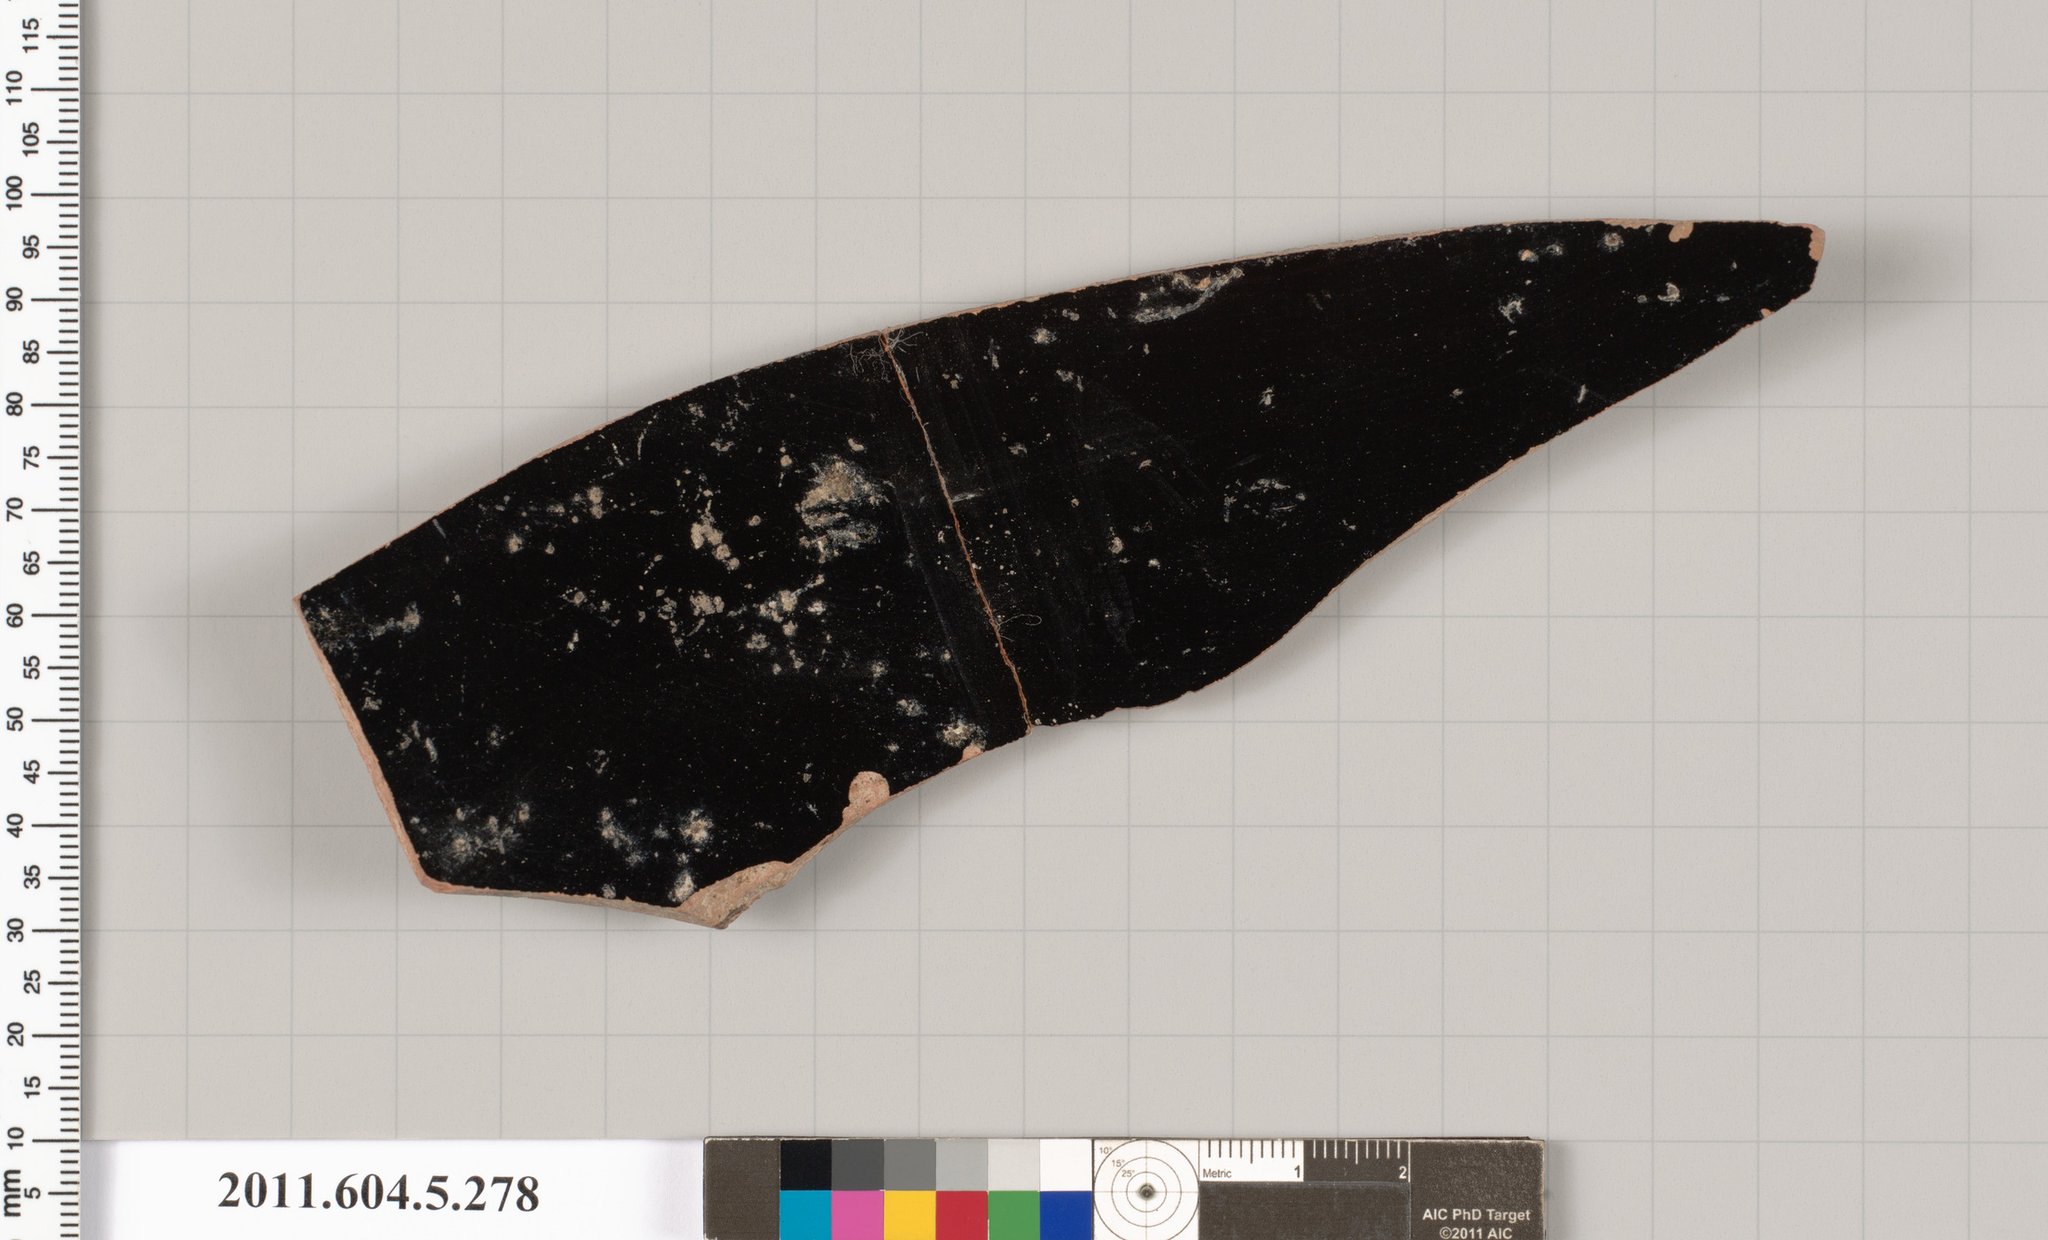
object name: kylix fragment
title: Terracotta fragment of a kylix (drinking cup)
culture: greek, attic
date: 600-401 BCE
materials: terracotta